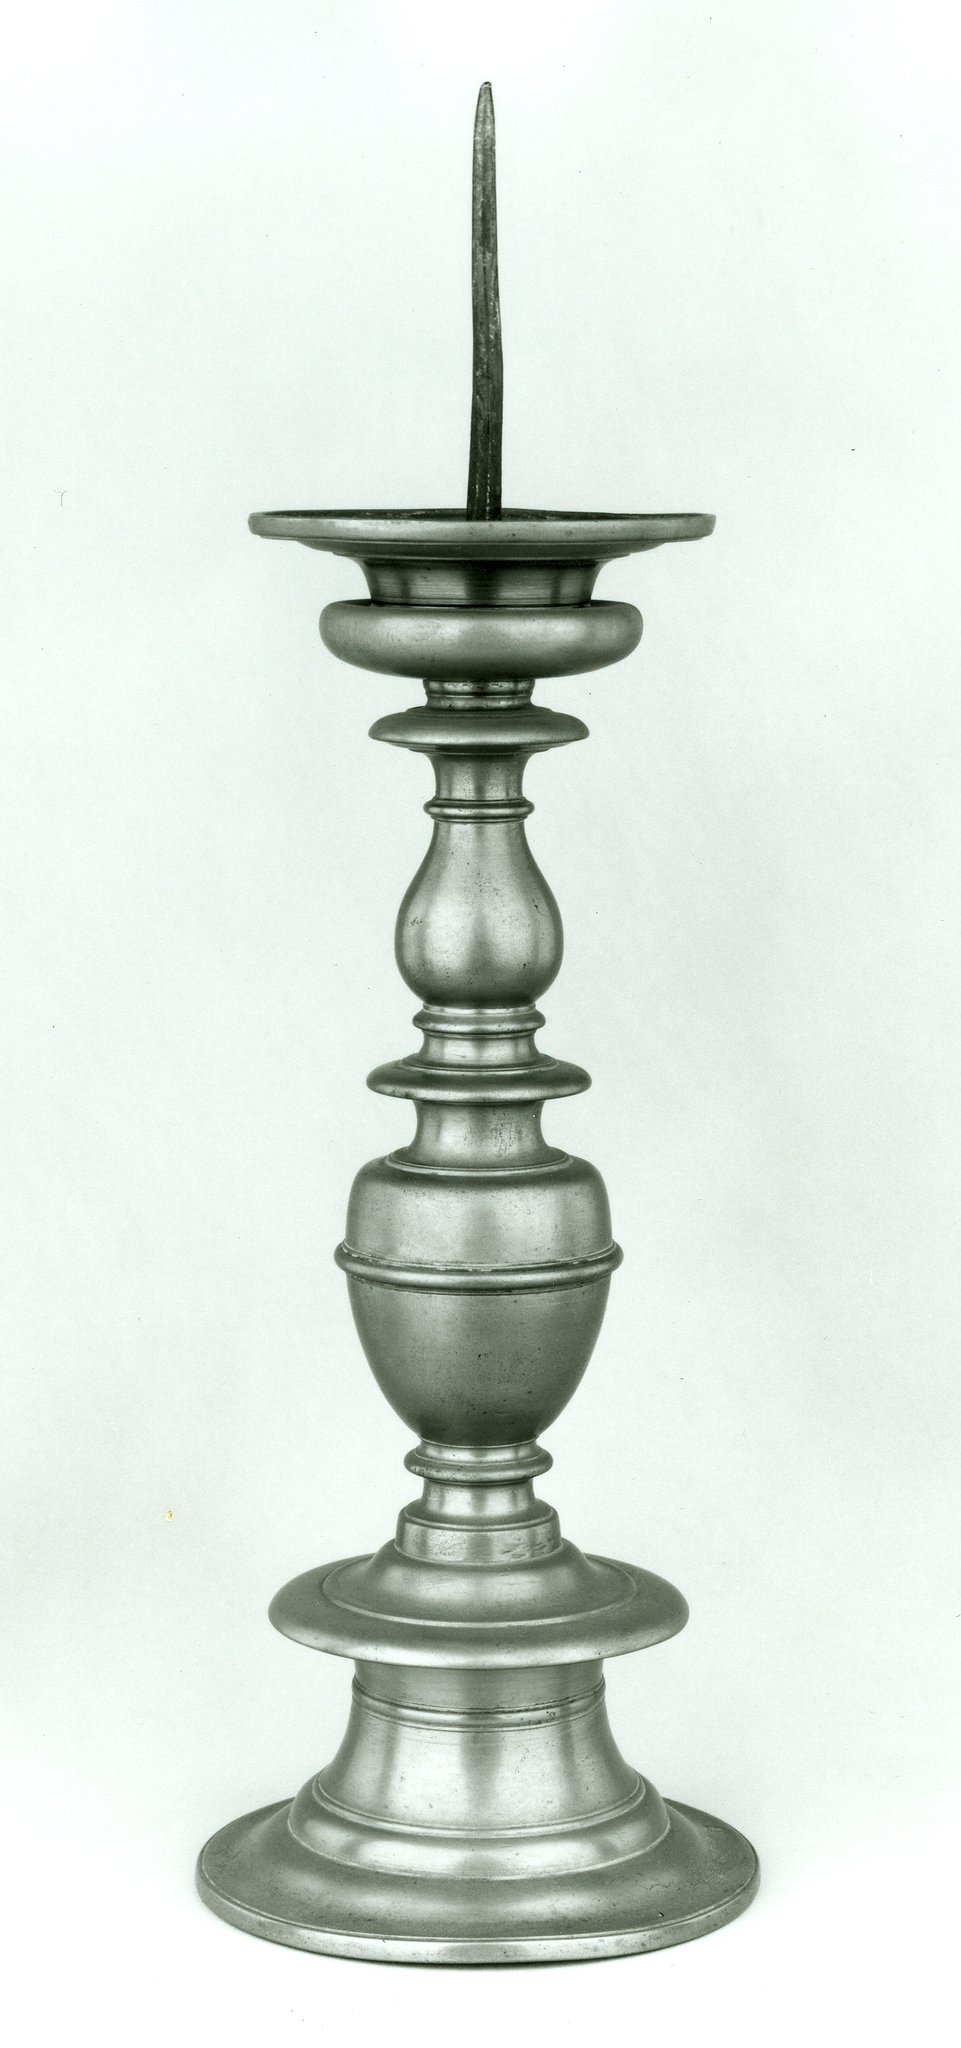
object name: candlestick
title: Altar Candlestick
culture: german or south netherlandish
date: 1601-1700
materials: brass